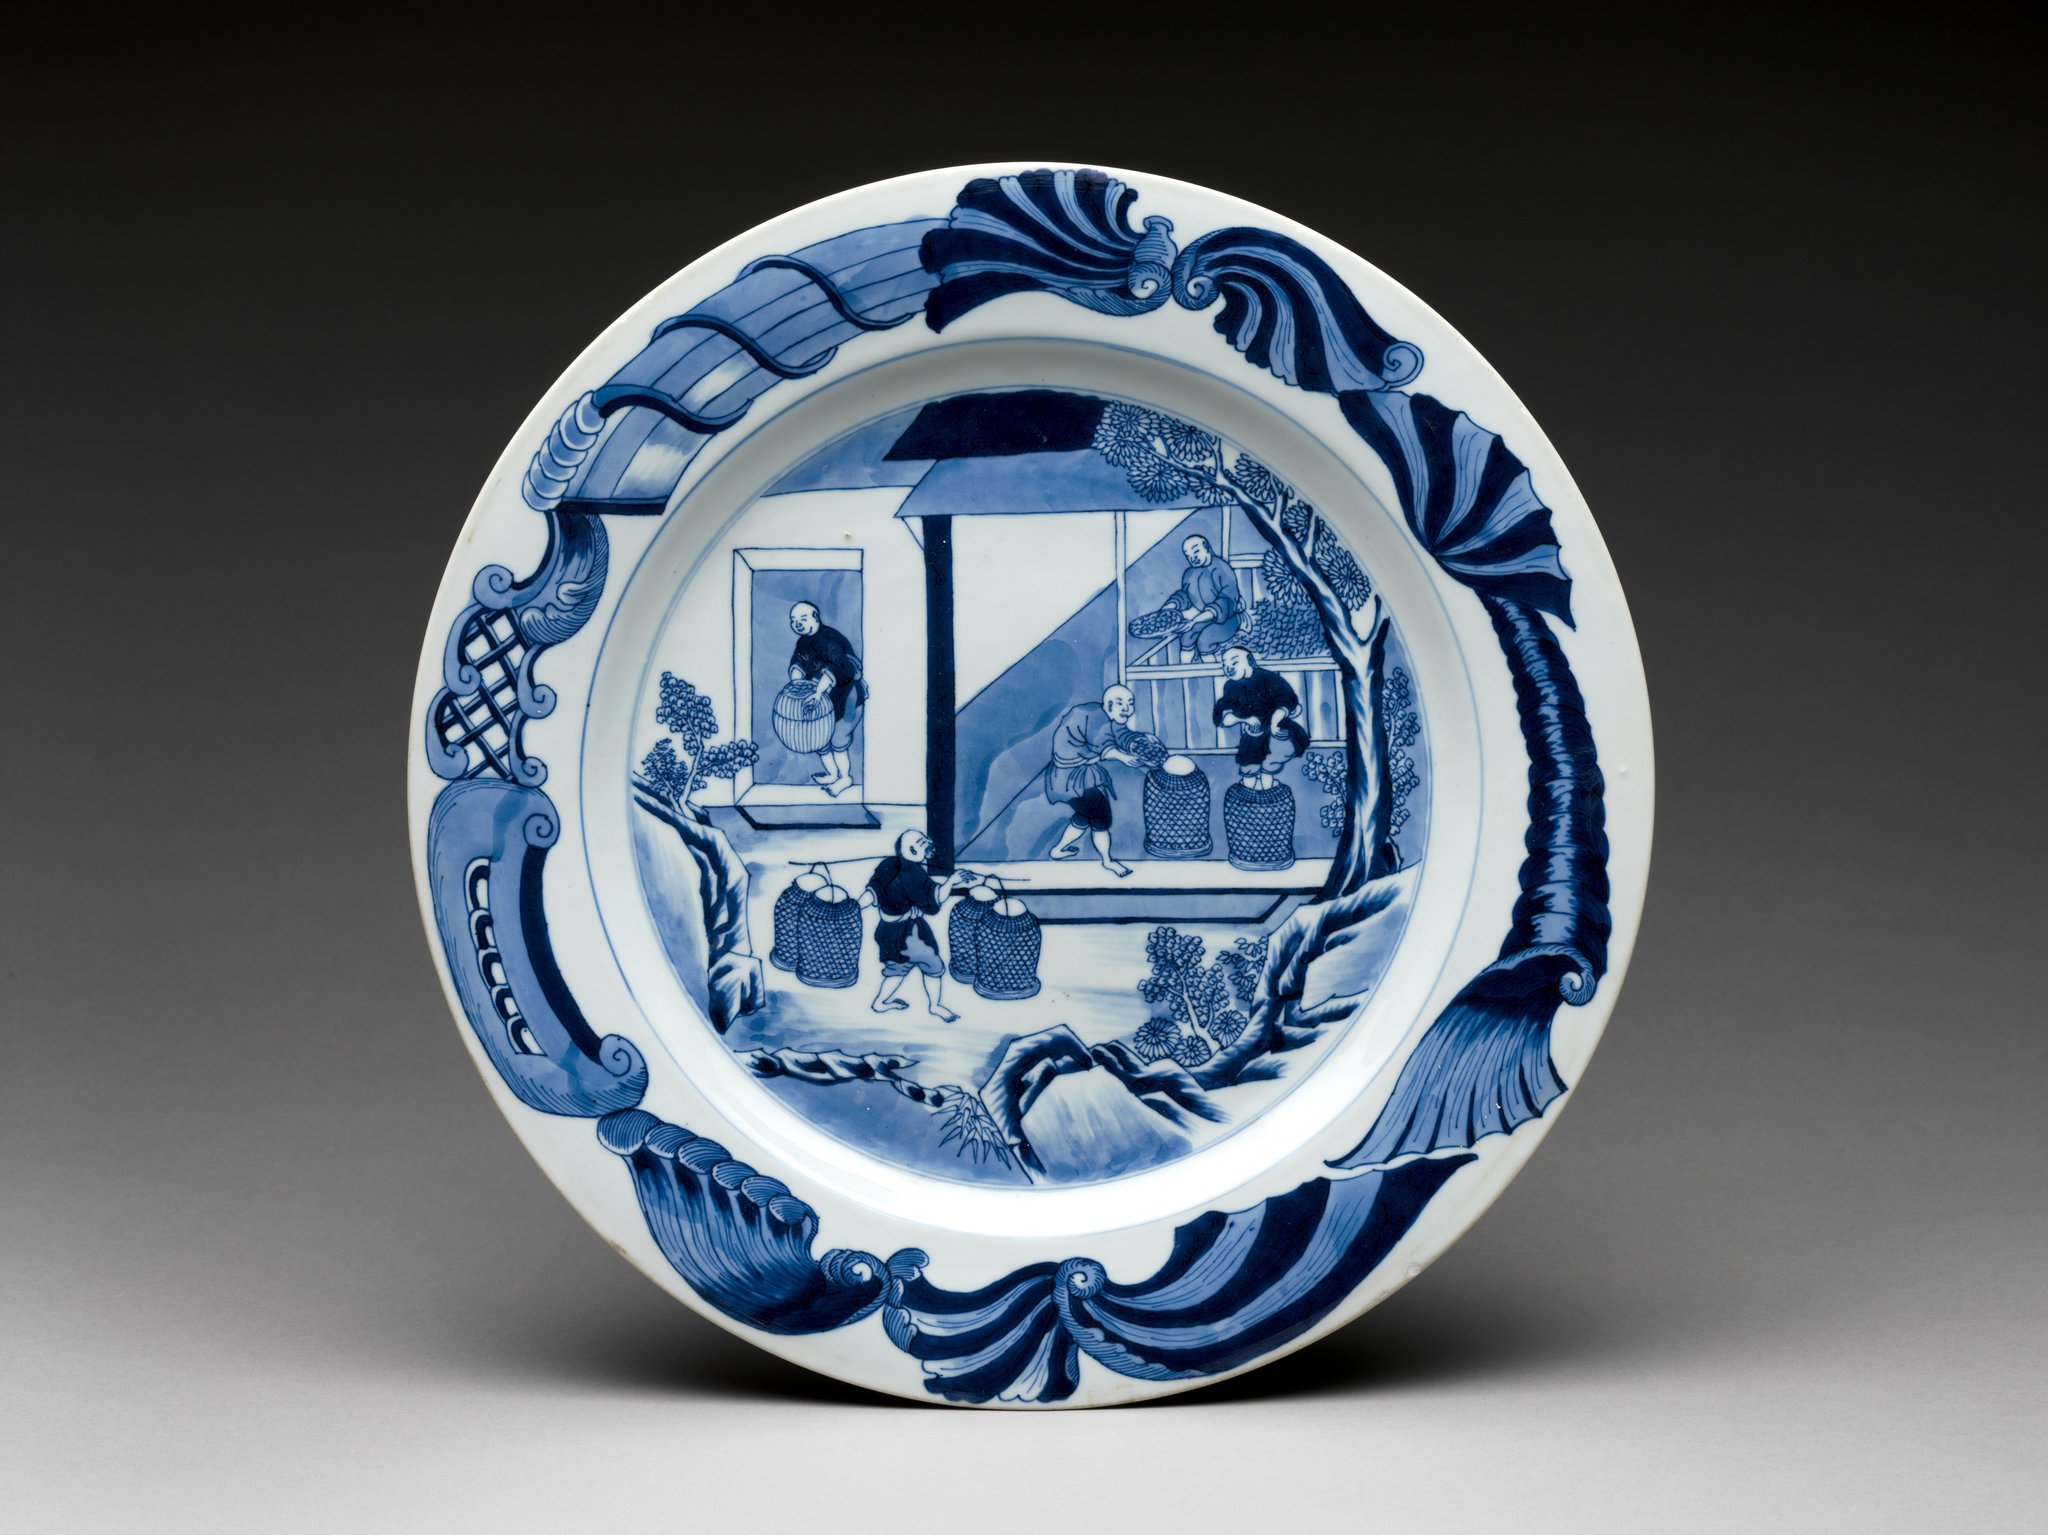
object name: dish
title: Dish with a scene of tea cultivation (one of a pair)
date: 1740-1745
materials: cobalt, glaze, hard paste porcelain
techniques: painting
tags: men,genre scene,working